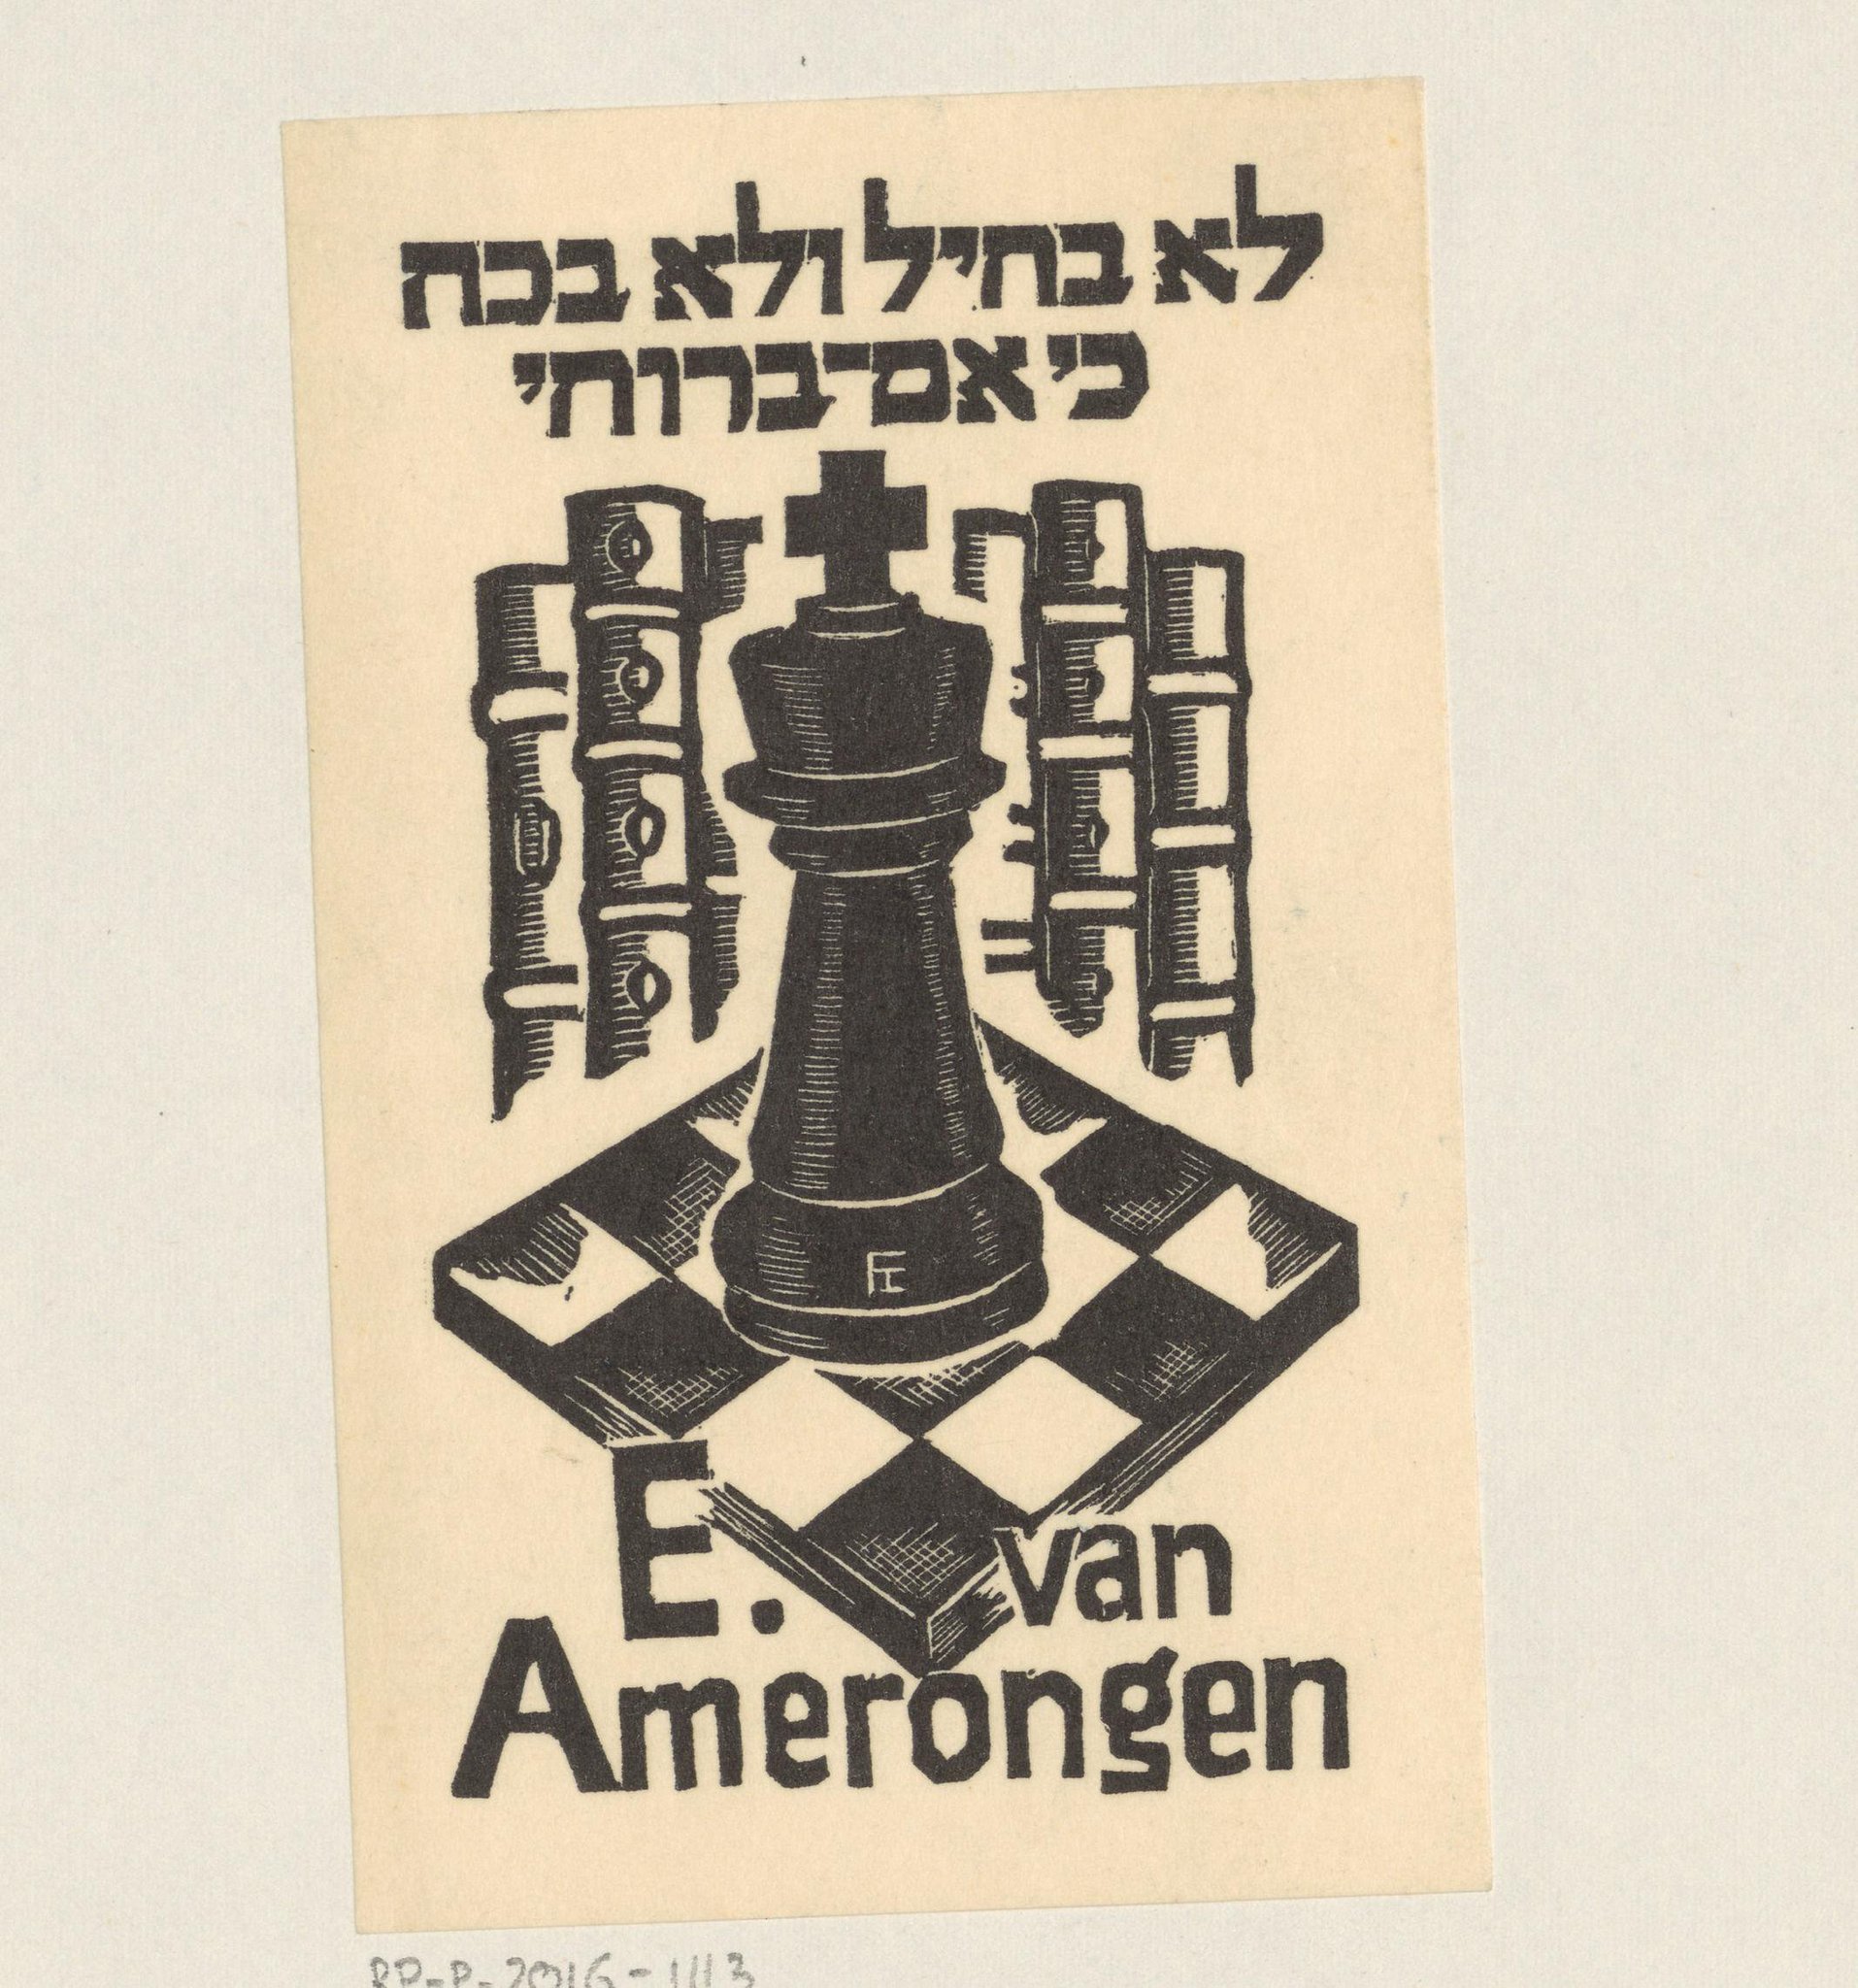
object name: bookplate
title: Ex libris van Eduard van Amerongen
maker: fré cohen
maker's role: draughtsman, print maker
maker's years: 1903-1943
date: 1938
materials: paper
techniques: woodcut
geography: netherlands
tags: chess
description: De Hebreeuwse tekst is afkomstig uit Zacharia 4:6 en wordt als volgt vertaald: 'Niet door kracht, noch door geweld, maar door mijn Geest.'